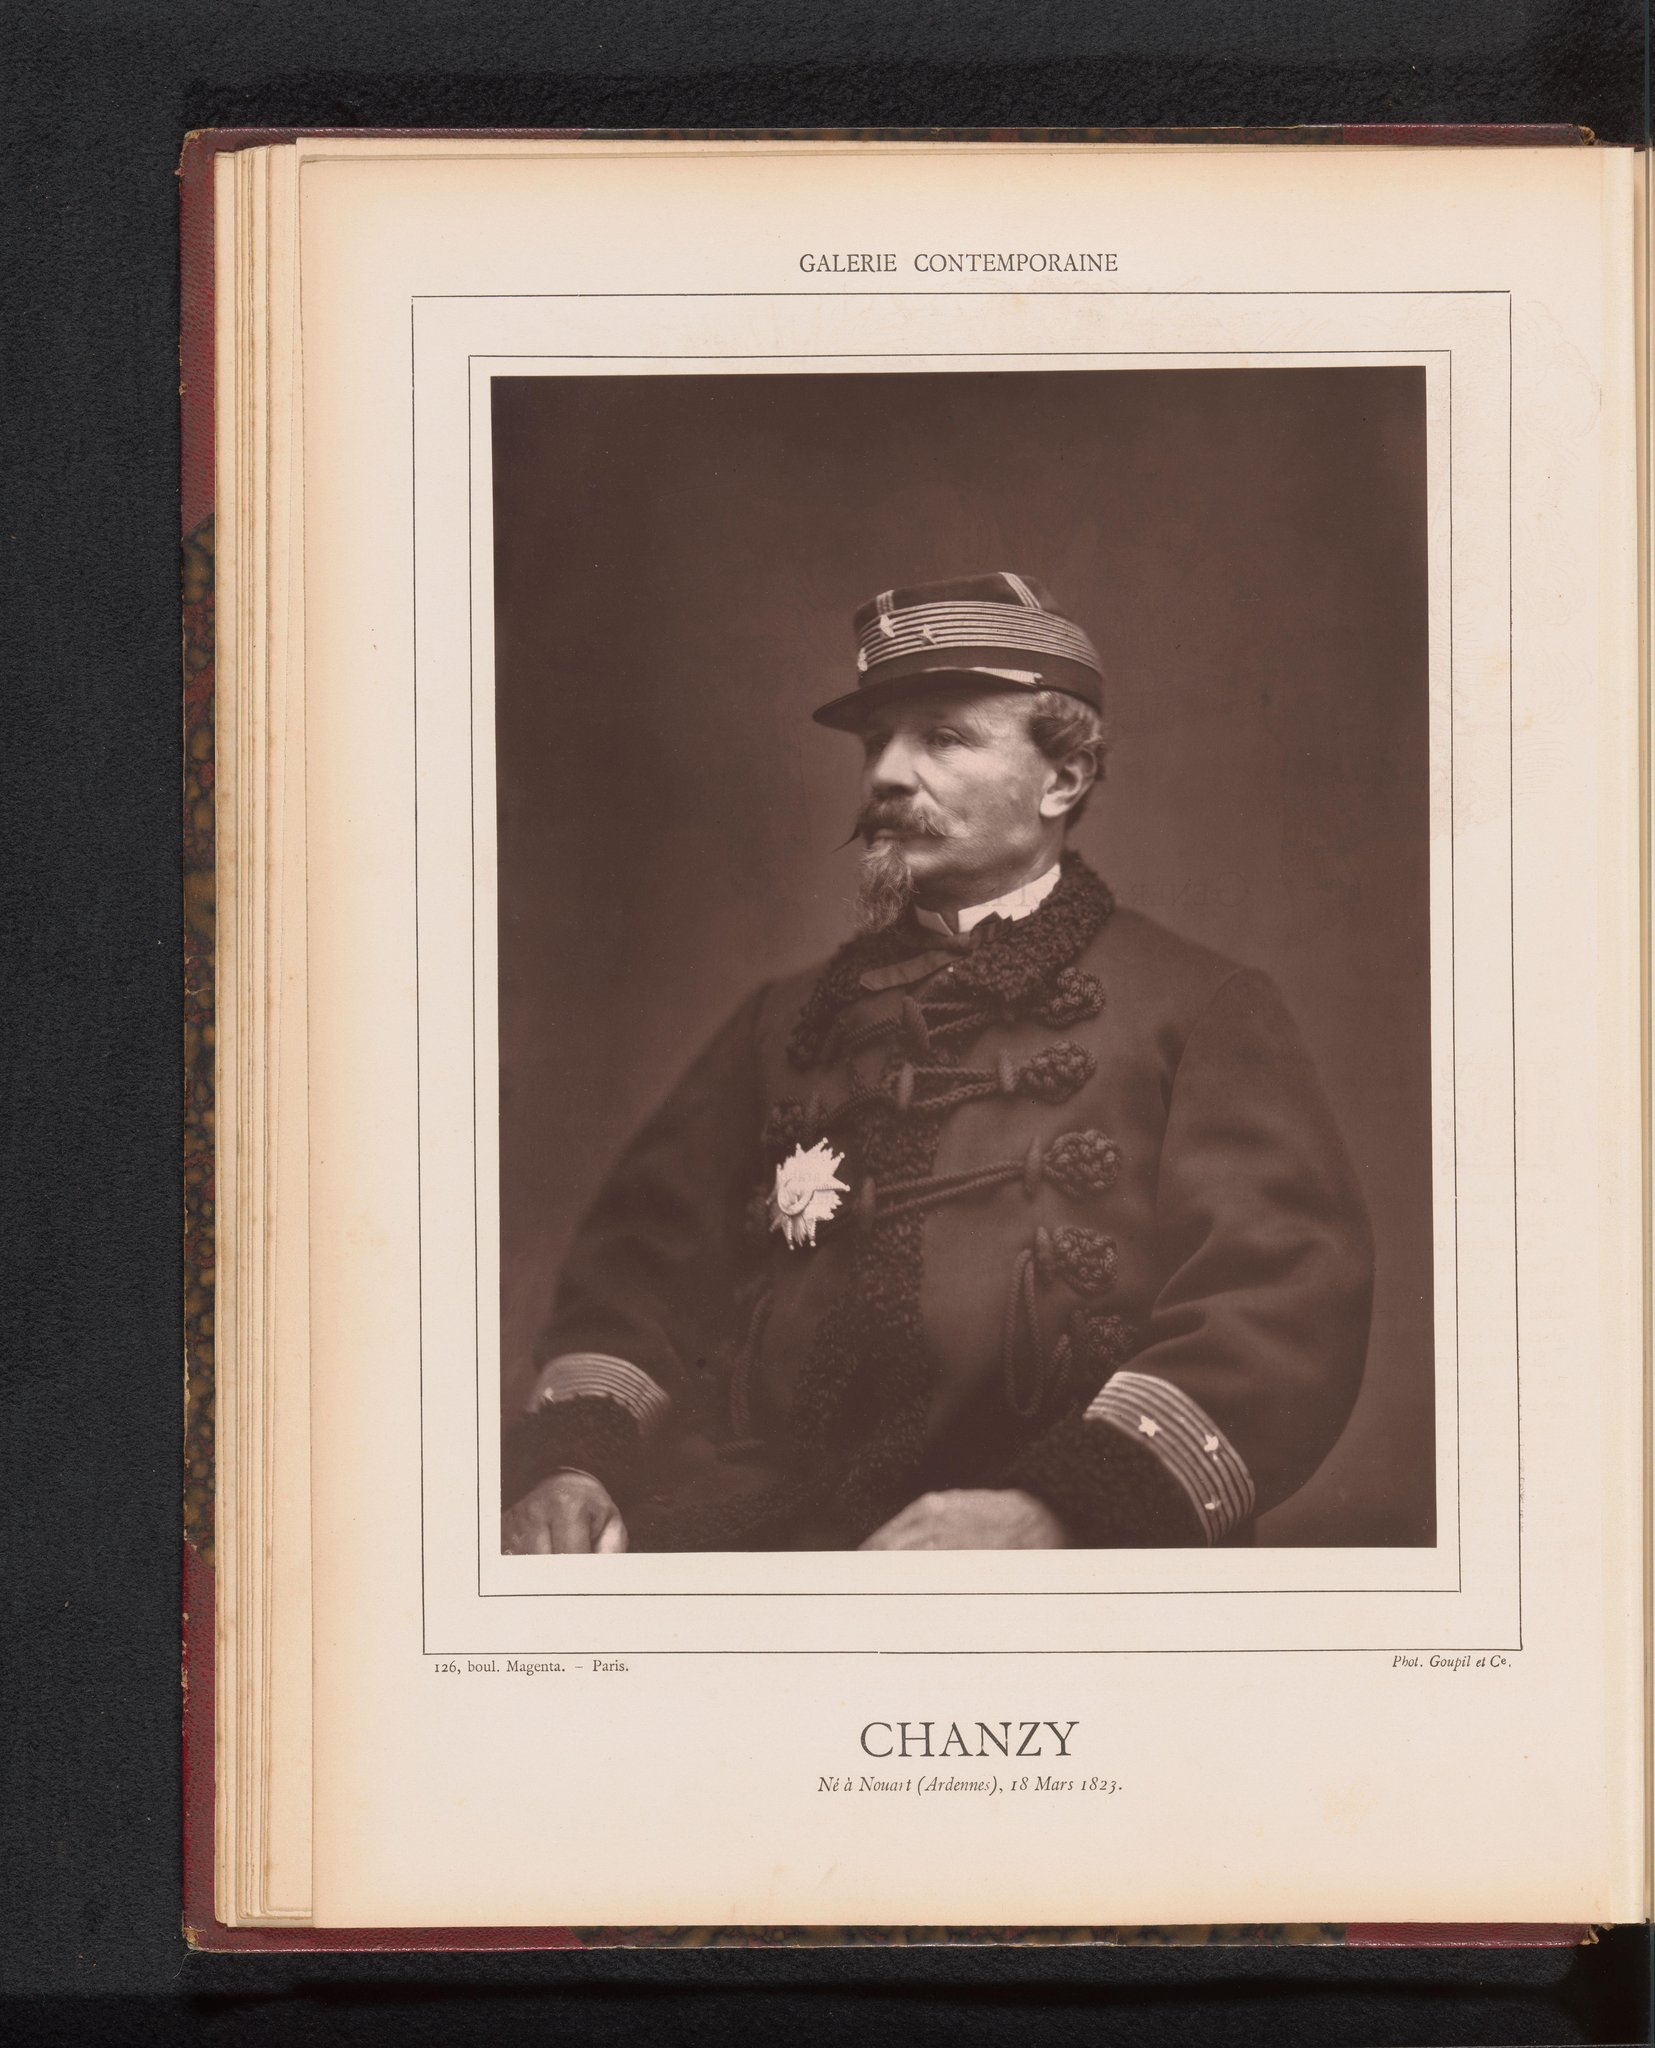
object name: photomechanical print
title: Chanzy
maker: Anonymous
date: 1873-1878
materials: paper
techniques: woodburytype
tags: adult man, historical persons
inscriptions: inscription: ‘Galerie Contemporaine, 126, boul. Magenta. - Paris./ Né à Nouart (Ardennes), 18 Mars 1823.’